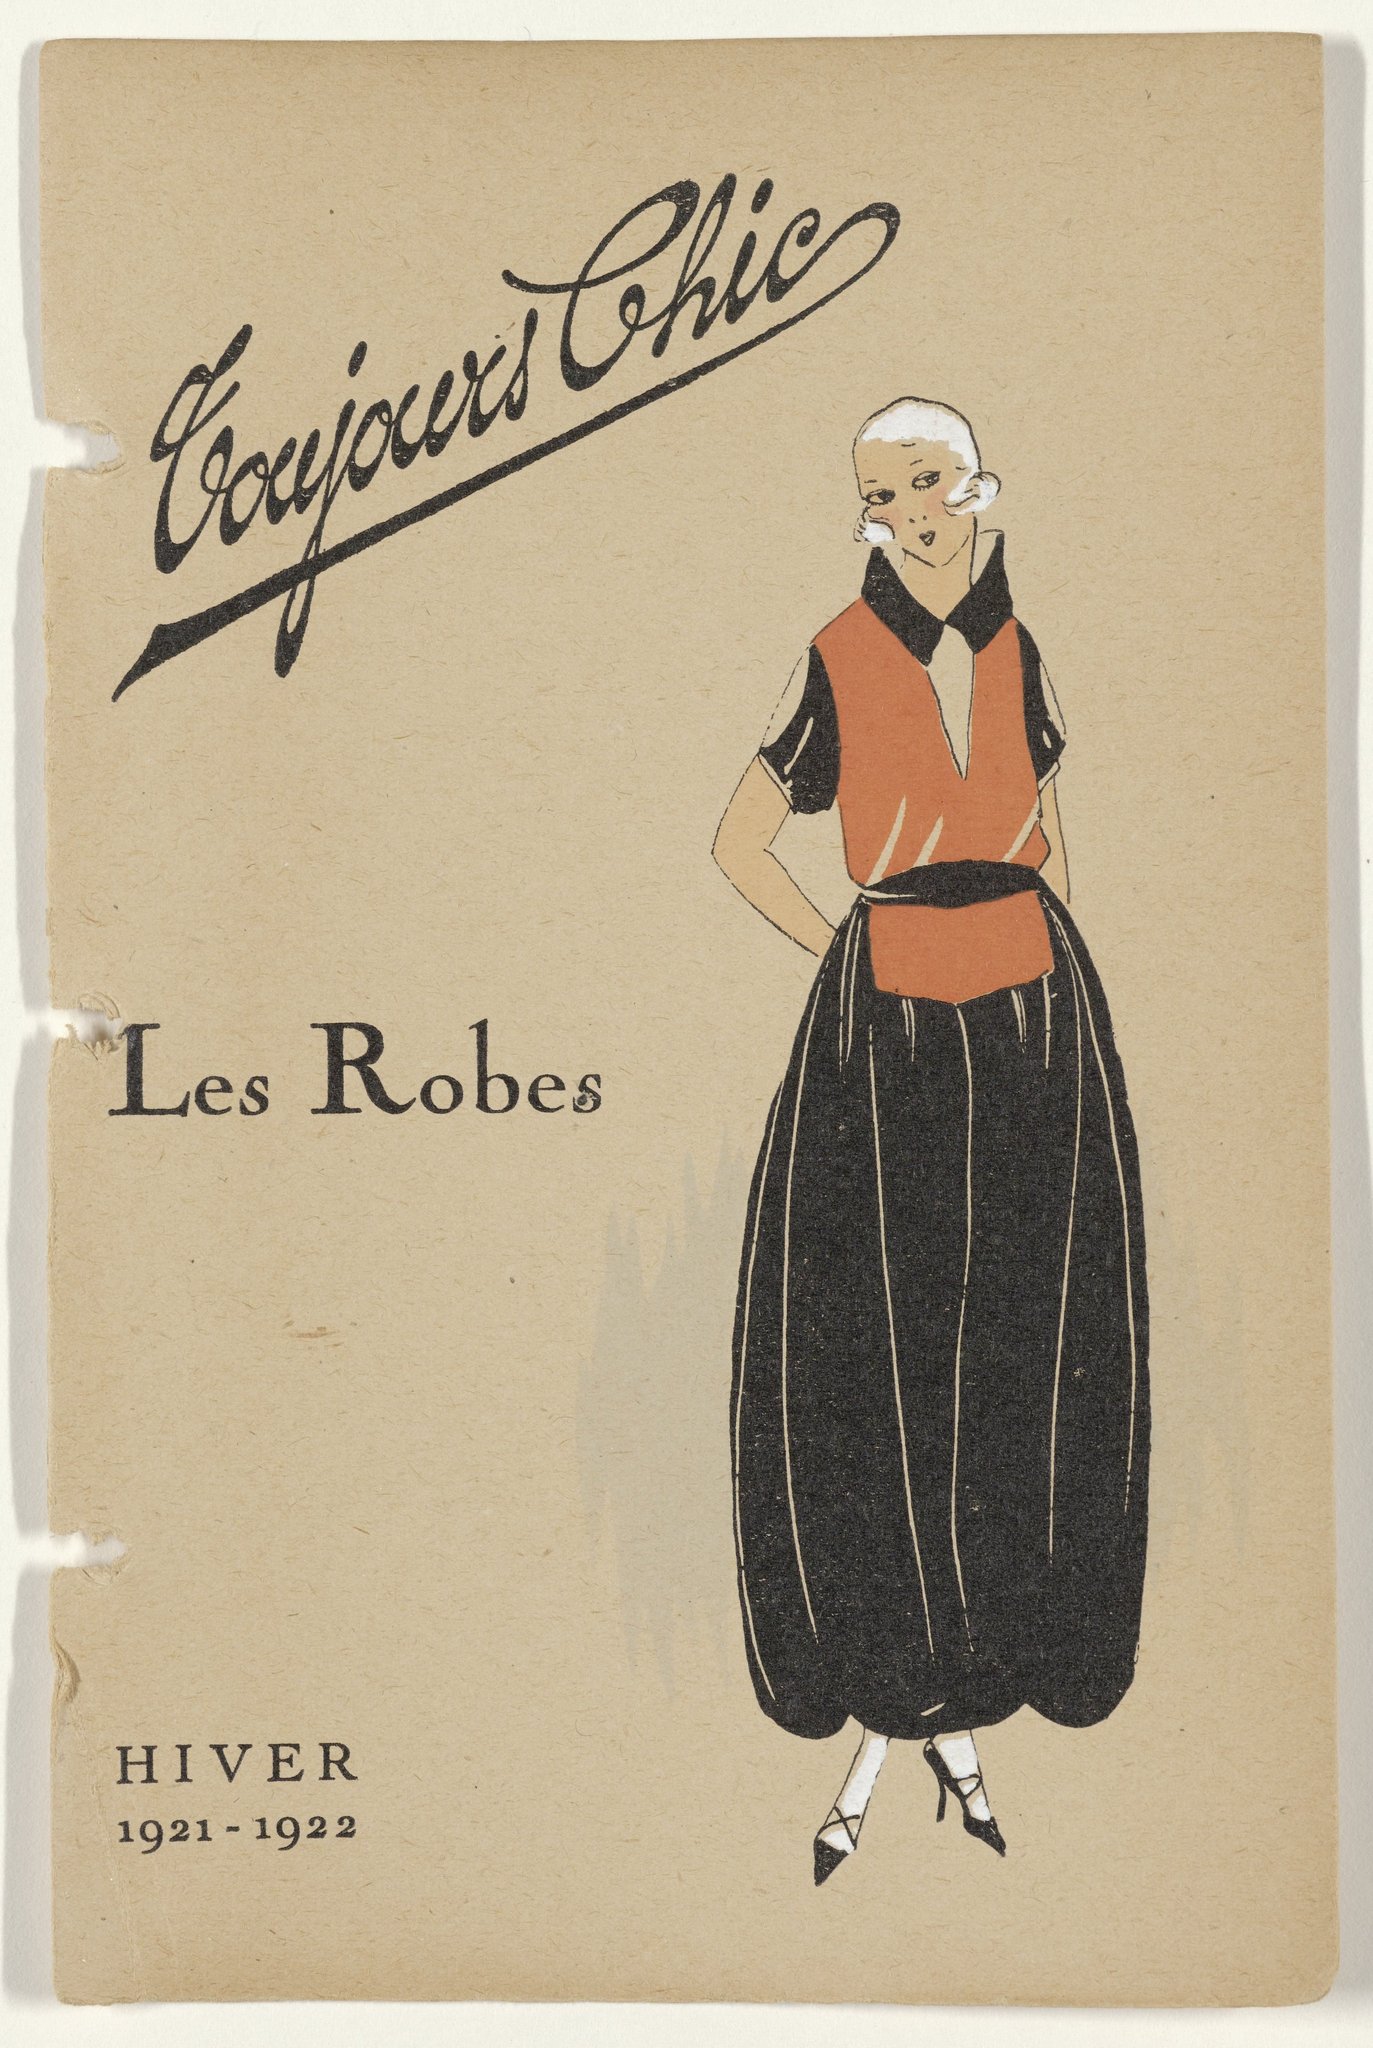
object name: titelblad, titelpagina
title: Toujours Chic Les Robes Hiver 1921-1922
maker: g-p. joumard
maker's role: publisher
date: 1921-1922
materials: paper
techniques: letterpress printing, pochoir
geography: paris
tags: fashion plates, dress, gown (+ women's clothes)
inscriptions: date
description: Titel "Toujours Chic: les Robes" en afbeelding van een japon in zwart, met rood lijfje. Pagina uit Catalogus "Toujours Chic" waarin een overzicht van de wintermode 1921-1922 in 80 prentjes in pochoir techniek.